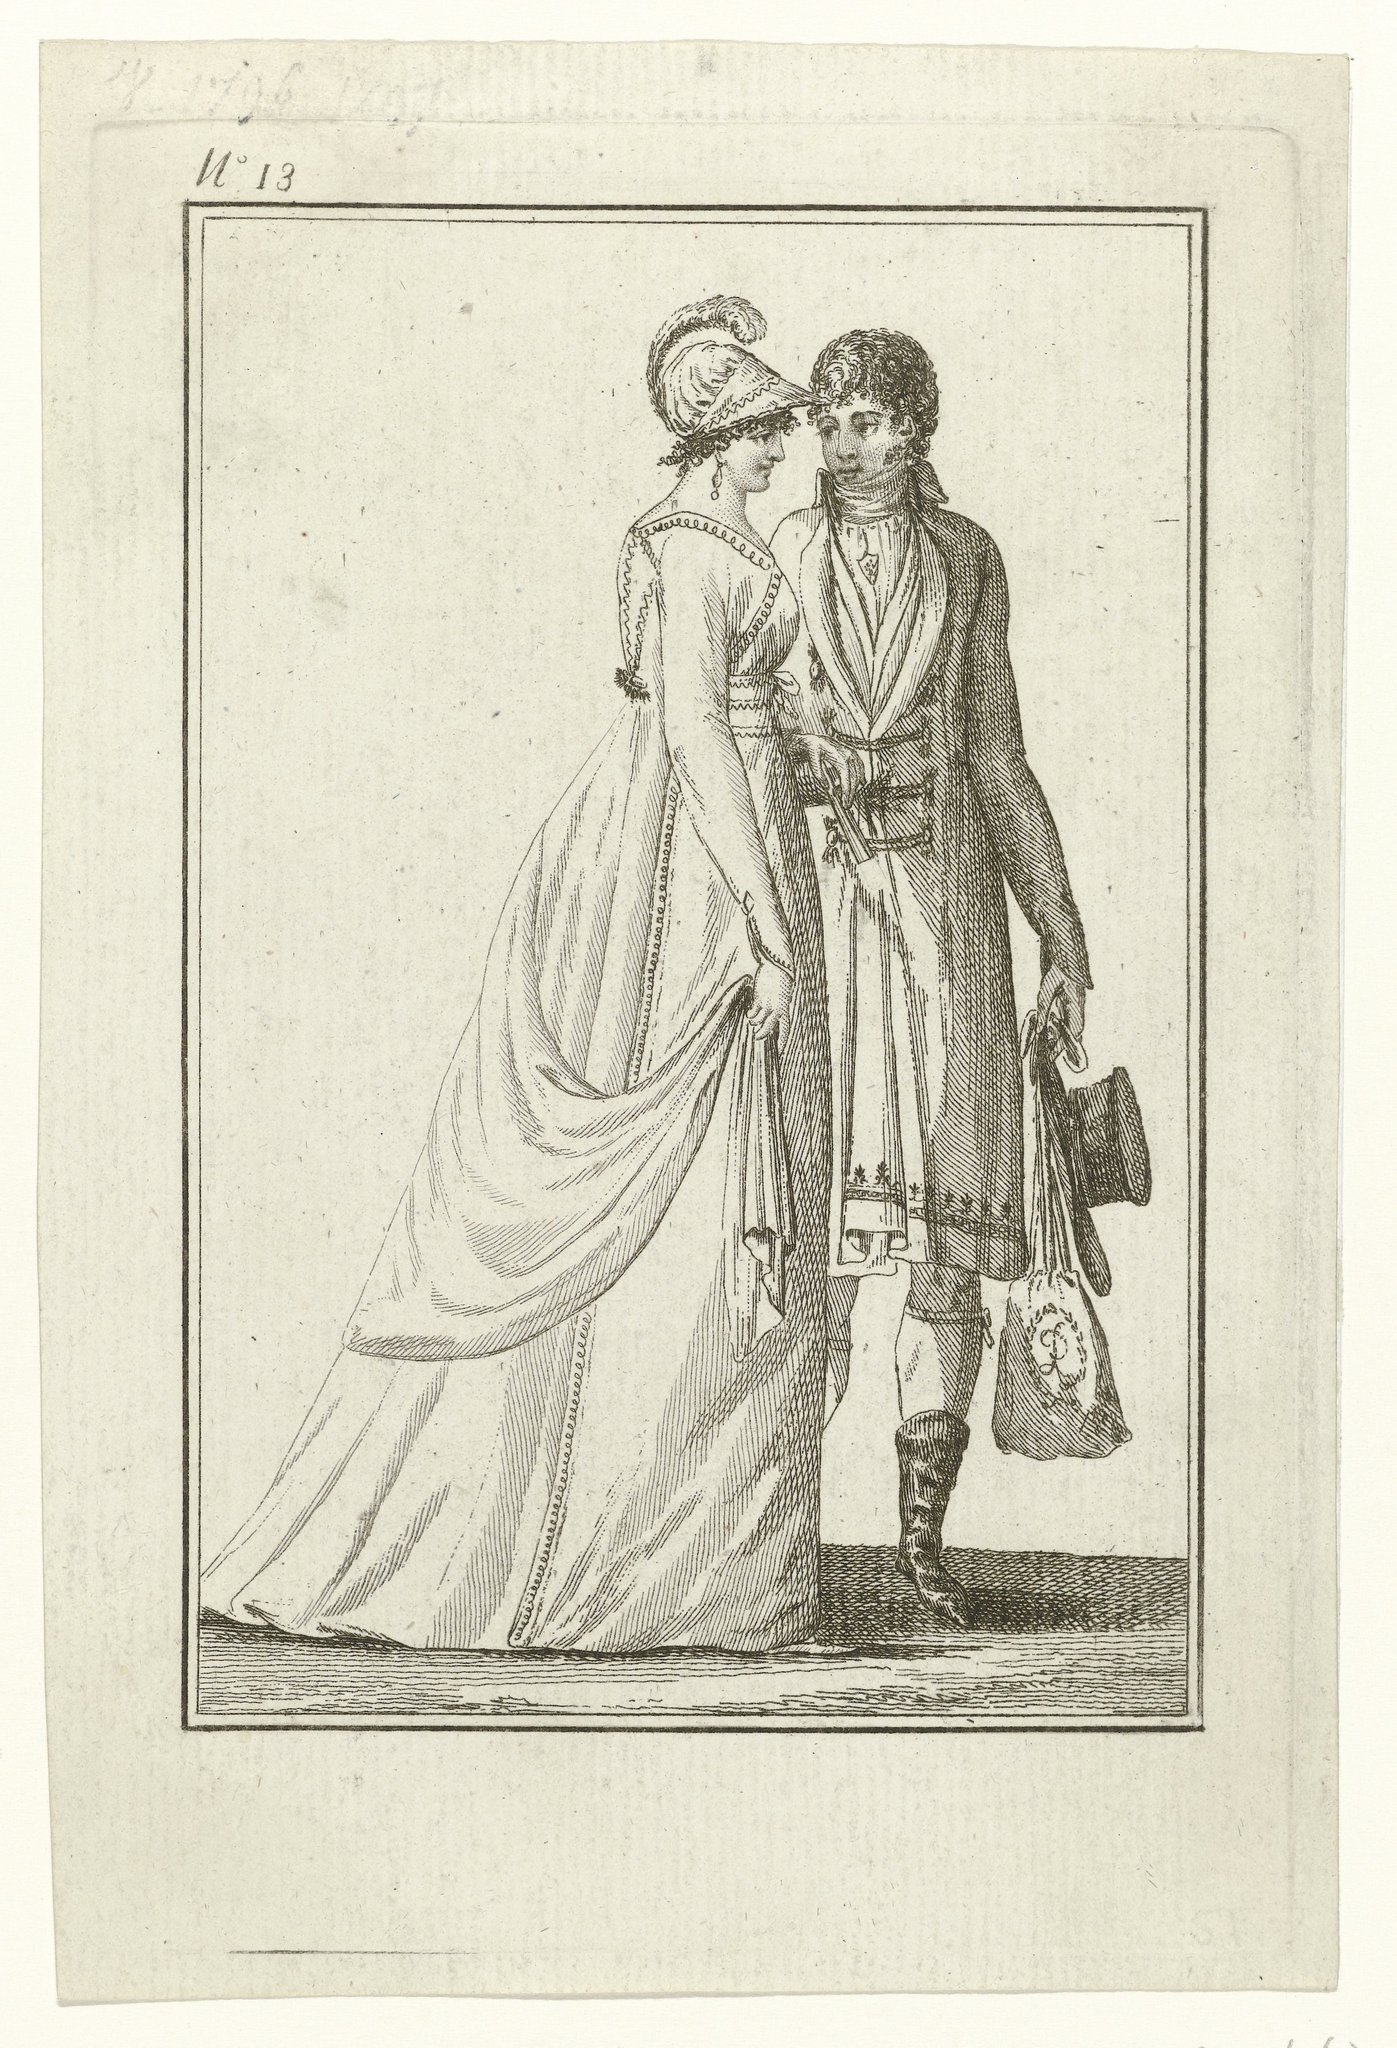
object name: fashion print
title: Tableau Général du Goût, An 7, No. 13 (21 dec. 1798): Couple amoureux à la promenade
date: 1798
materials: paper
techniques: etching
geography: paris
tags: clothing for the upper part of the body (vest) (+ men's clothes), ear-rings (+ women's clothes), clothing for the upper part of the body (shawl) (+ women's clothes), bag (reticule) (+ women's clothes), neck-gear ~ clothing (shawl collar) (+ men's clothes), coat (+ men's clothes), head-gear: hat (+ men's clothes), fashion plates, head-gear: hat (+ women's clothes), dress, gown (+ women's clothes), fan (+ women's clothes), trousers, breeches, etc. (breeches) (+ men's clothes), boots (+ men's clothes)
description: Amoureus paar wandelend op de promenade. De vrouw draagt een japon met lange mouwen en sleep, afgezet met lussenpatroon. Accessoires: hoed met veer, oorbel in het rechteroor, waaier, sjaal. De man draagt een jas met sjaalkraag, vest en kniebroek. Zijn hoed en de reticule van de vrouw, met de initialen L en G, in de hand. Laarzen met puntige neuzen. De prent maakt deel uit van een reeks van 20 modeprenten, uitgegeven door Gide, Parijs, An VII, 1797- 1799.